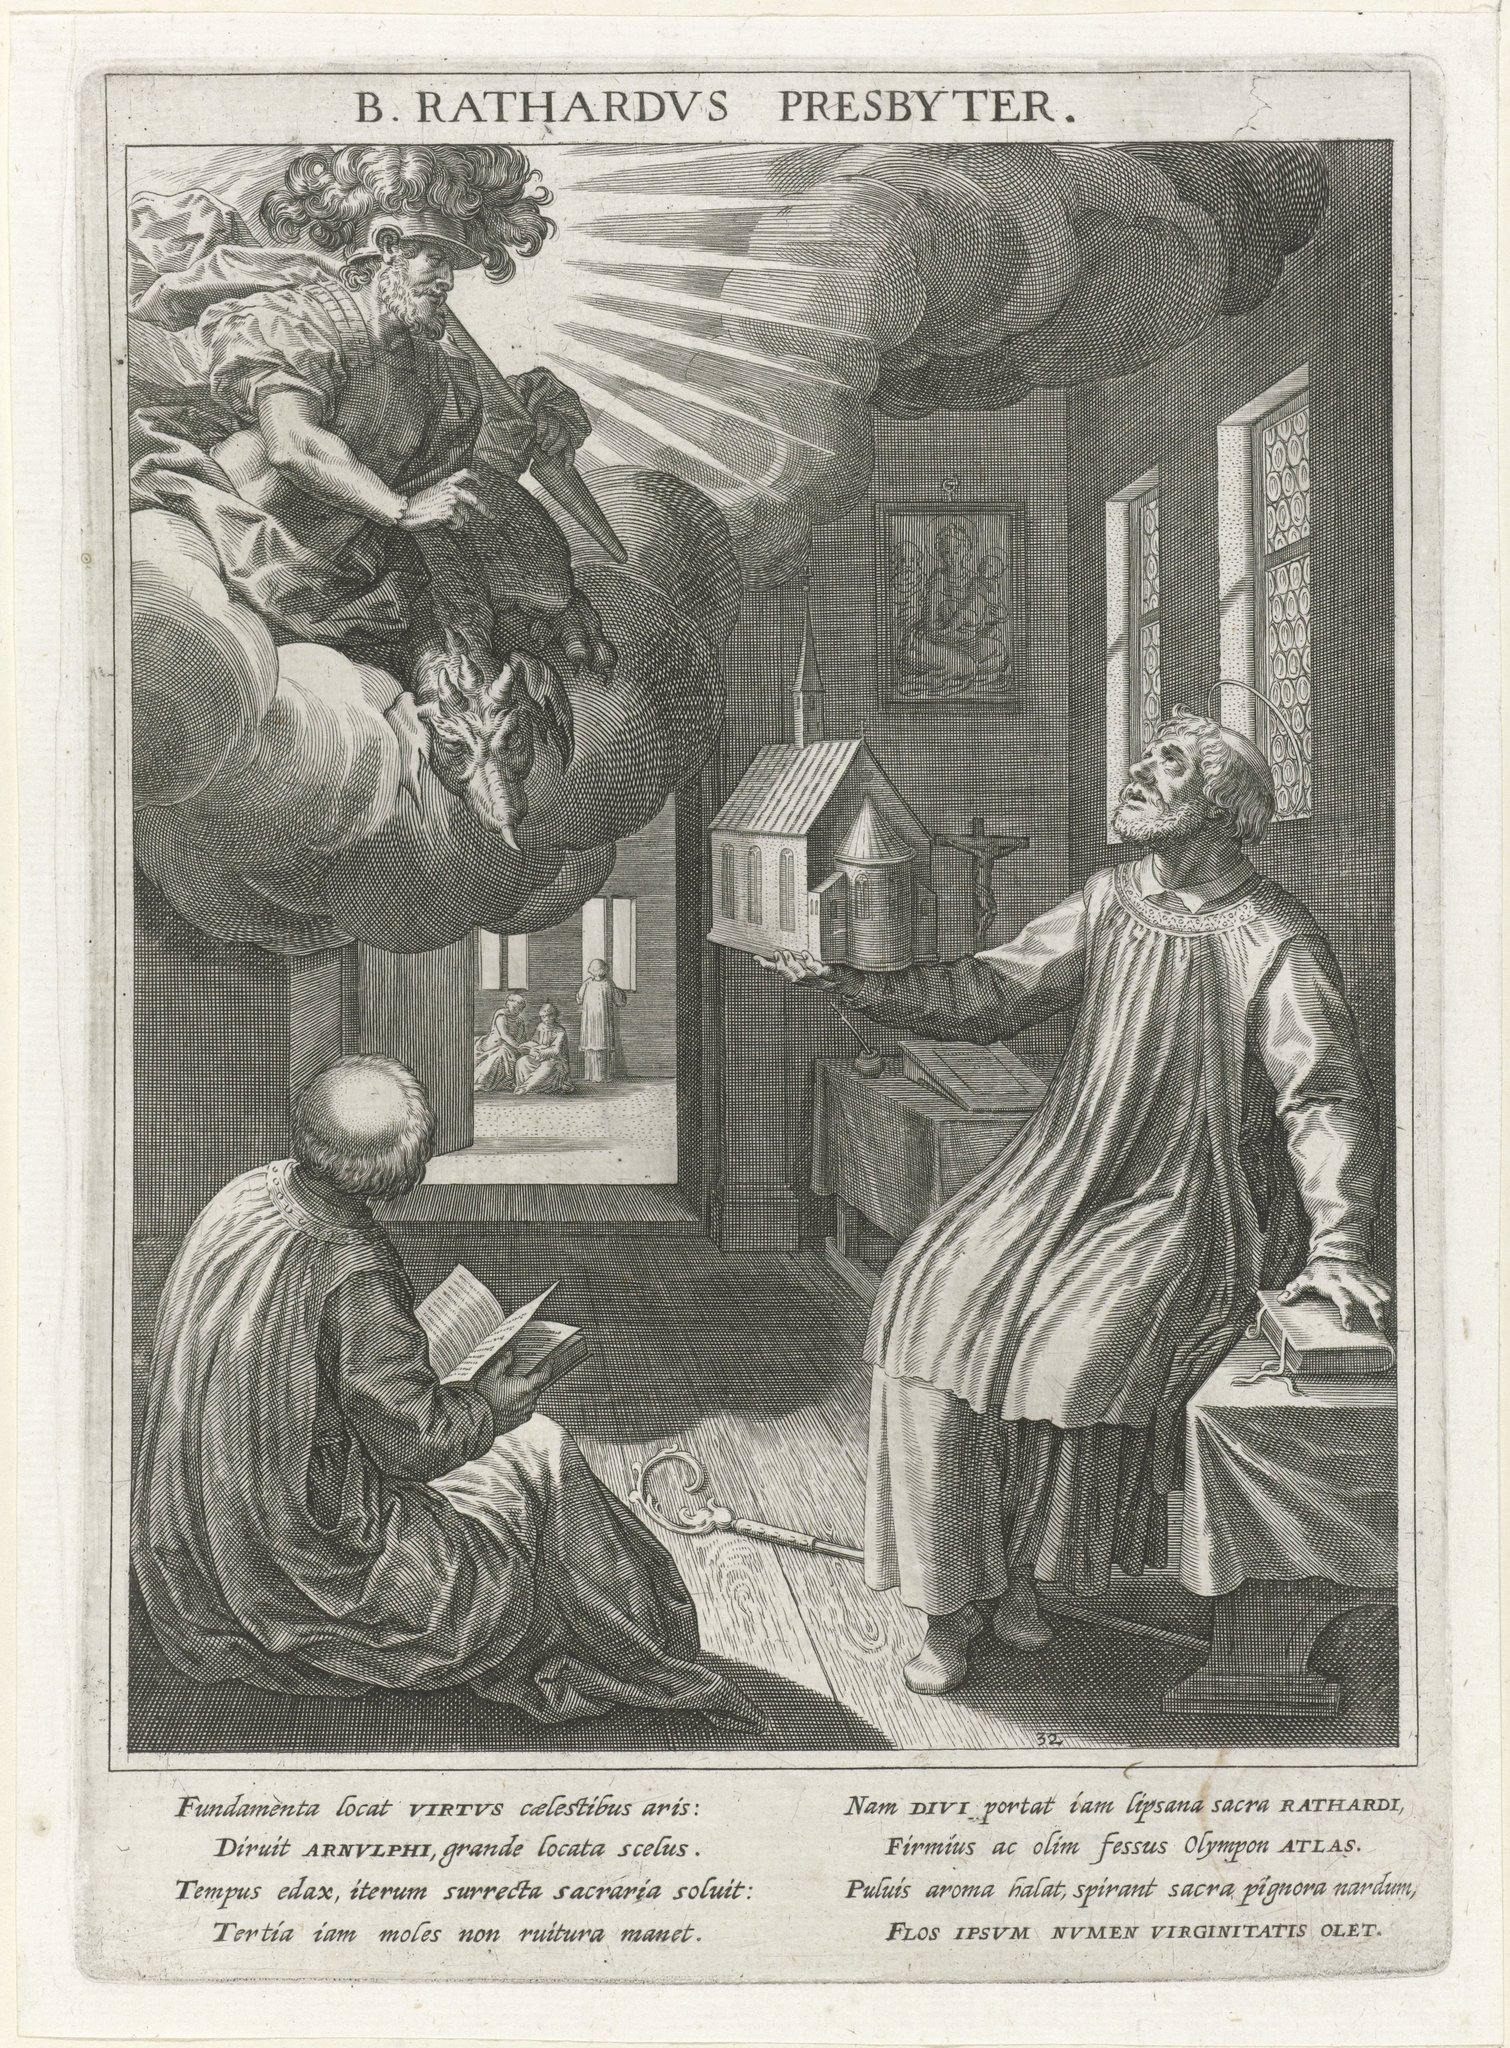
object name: print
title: Aartsengel Michaël verschijnt aan Rathard van Diessen-Andechs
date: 1615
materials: paper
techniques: engraving, etching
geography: munich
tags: patron handing over model of church (or chapel), michael resting beside the dragon's corpse, male saints (with name), monk(s), friar(s)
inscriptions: collector's mark: Lugt 240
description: Aartsengel Michaël (in harnas met naast hem de verslagen draak) verschijnt aan de zalige Rathard van Diessen-Andechs, die het model van het augustijnenklooster van Diessen in zijn rechterhand houdt. De prent heeft een Latijns onderschrift en is de 32ste prent van een 60-delige serie met als onderwerp de heiligen van Beieren.